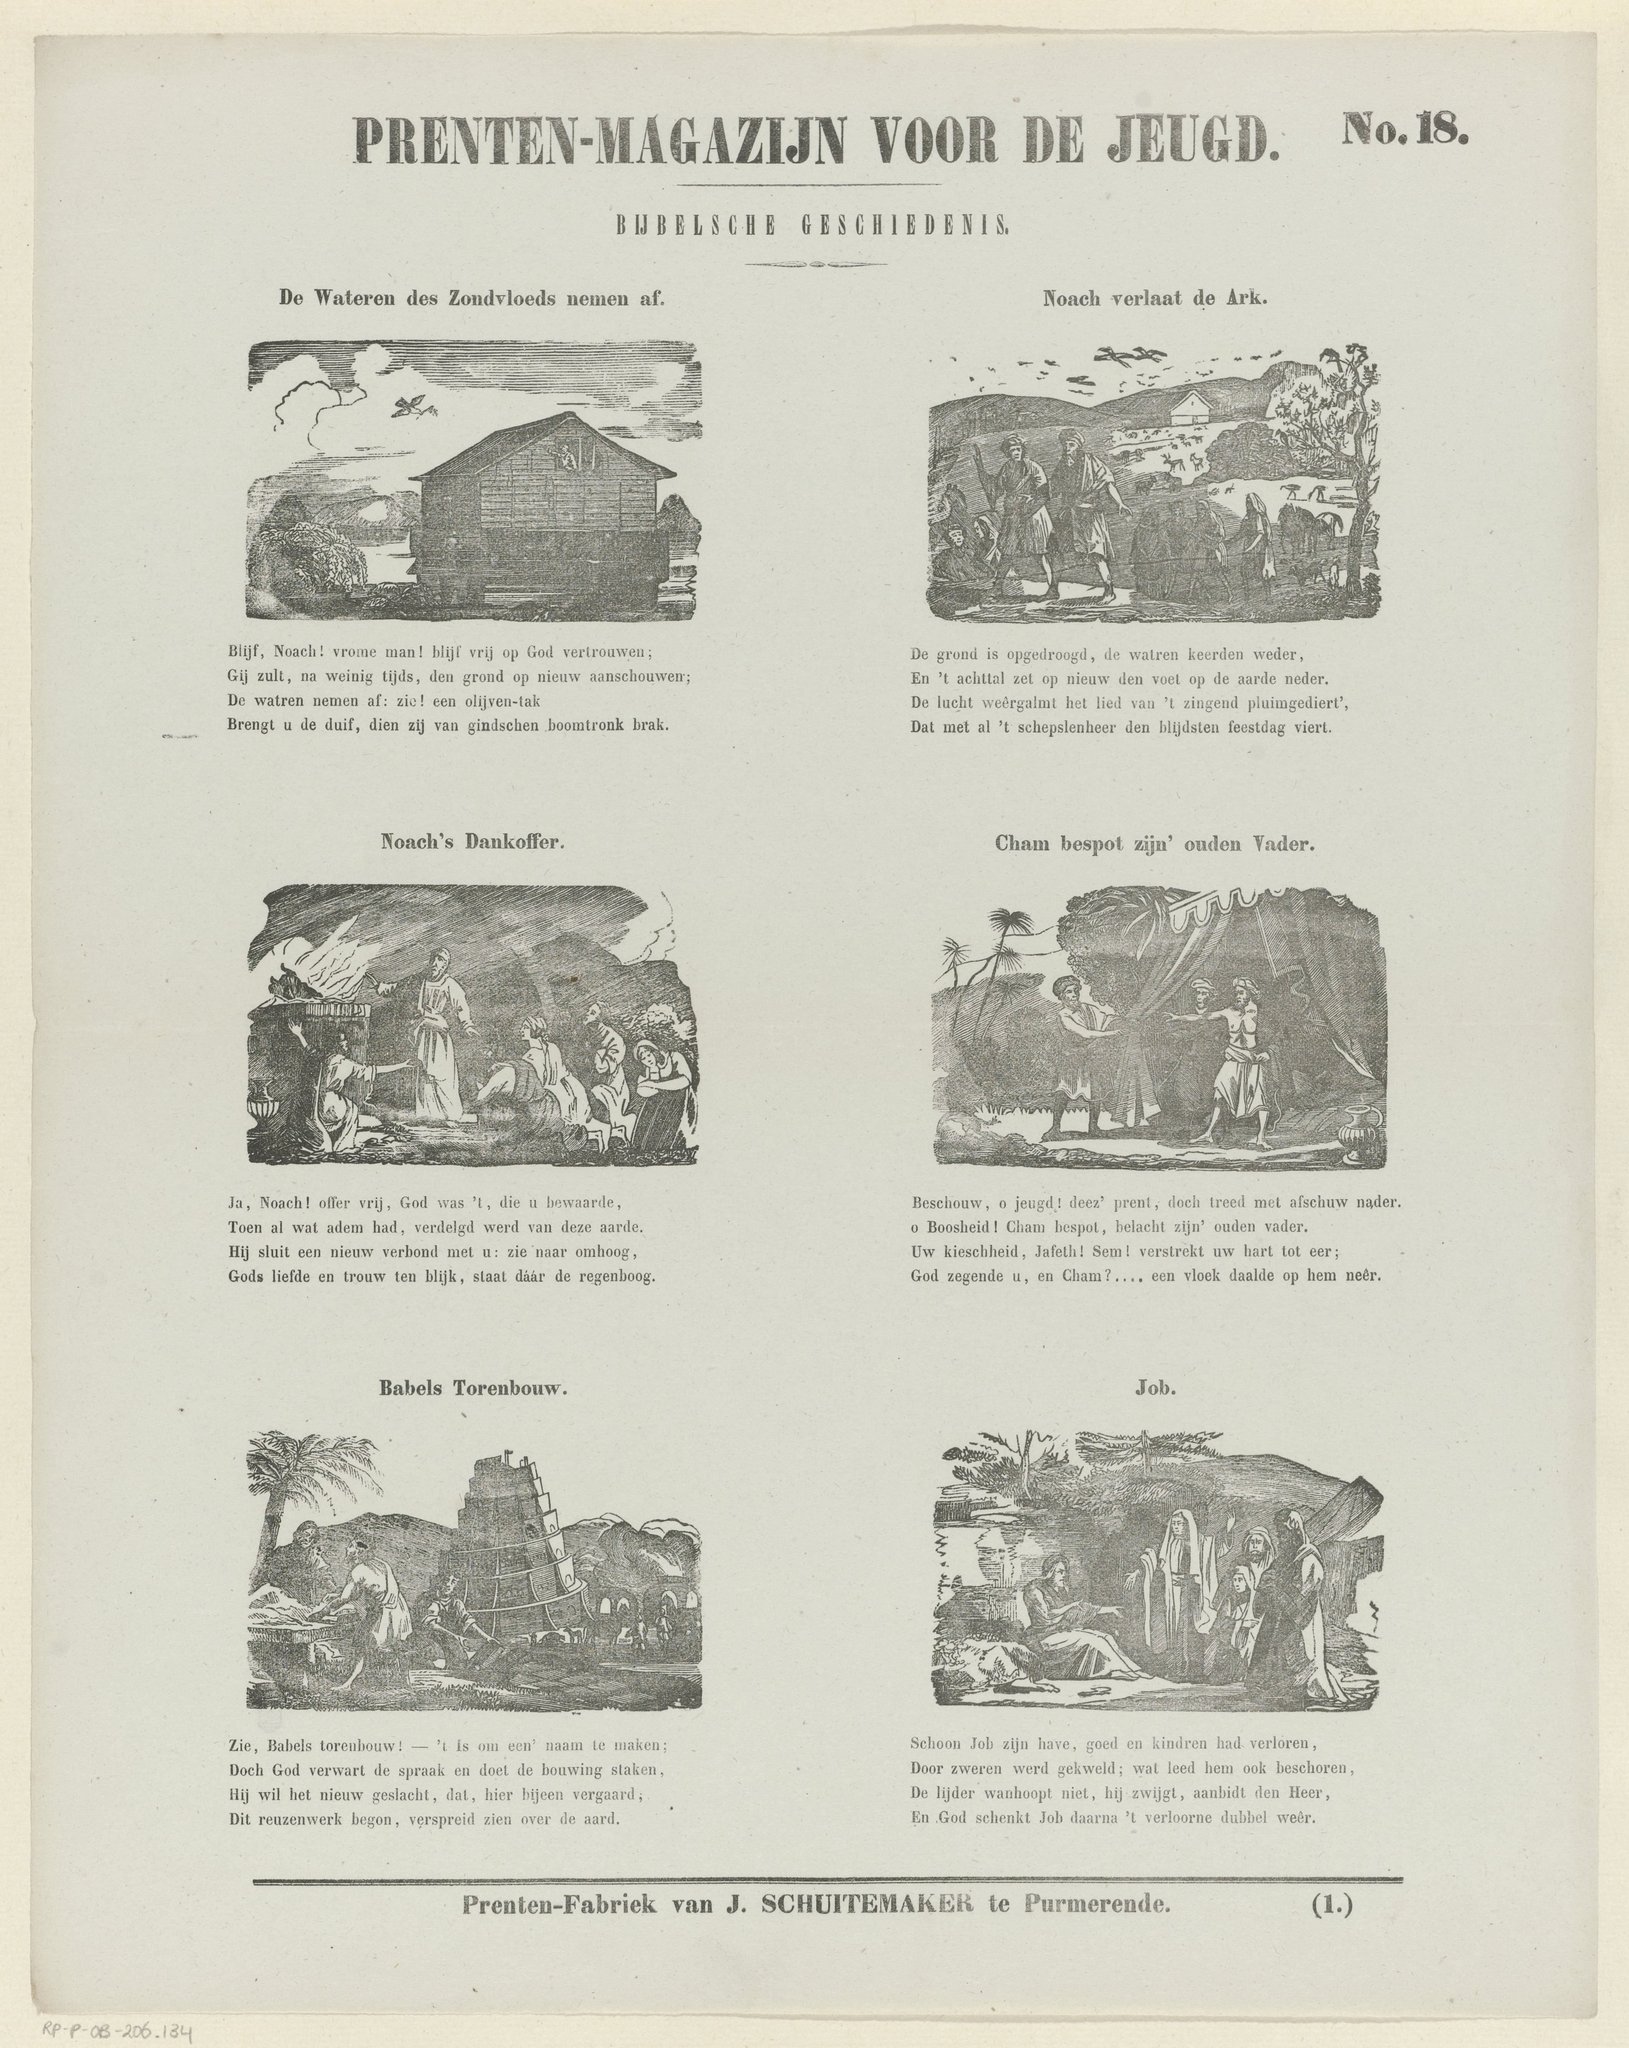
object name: popular print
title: Scènes uit het Oude Testament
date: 1850-1881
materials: paper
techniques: letterpress printing, engraving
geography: purmerend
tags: job's former wealth is doubled, the tower of babel, story of noah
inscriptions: collector's mark: Lugt 2760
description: Na voltooiing van de acht jaargangen van de reeks 'Prenten-magazijn voor de jeugd' in 1850 heeft Jan Schuitemaker al deze prenten heruitgegeven en omgenummerd als nr. 1 t/m 192. De oorspronkelijke jaargang wordt telkens nog vermeld rechtsonder op de prent. Binnen de jaargangen zijn prenten van hetzelfde thema in clusters van vier achter elkaar gezet.